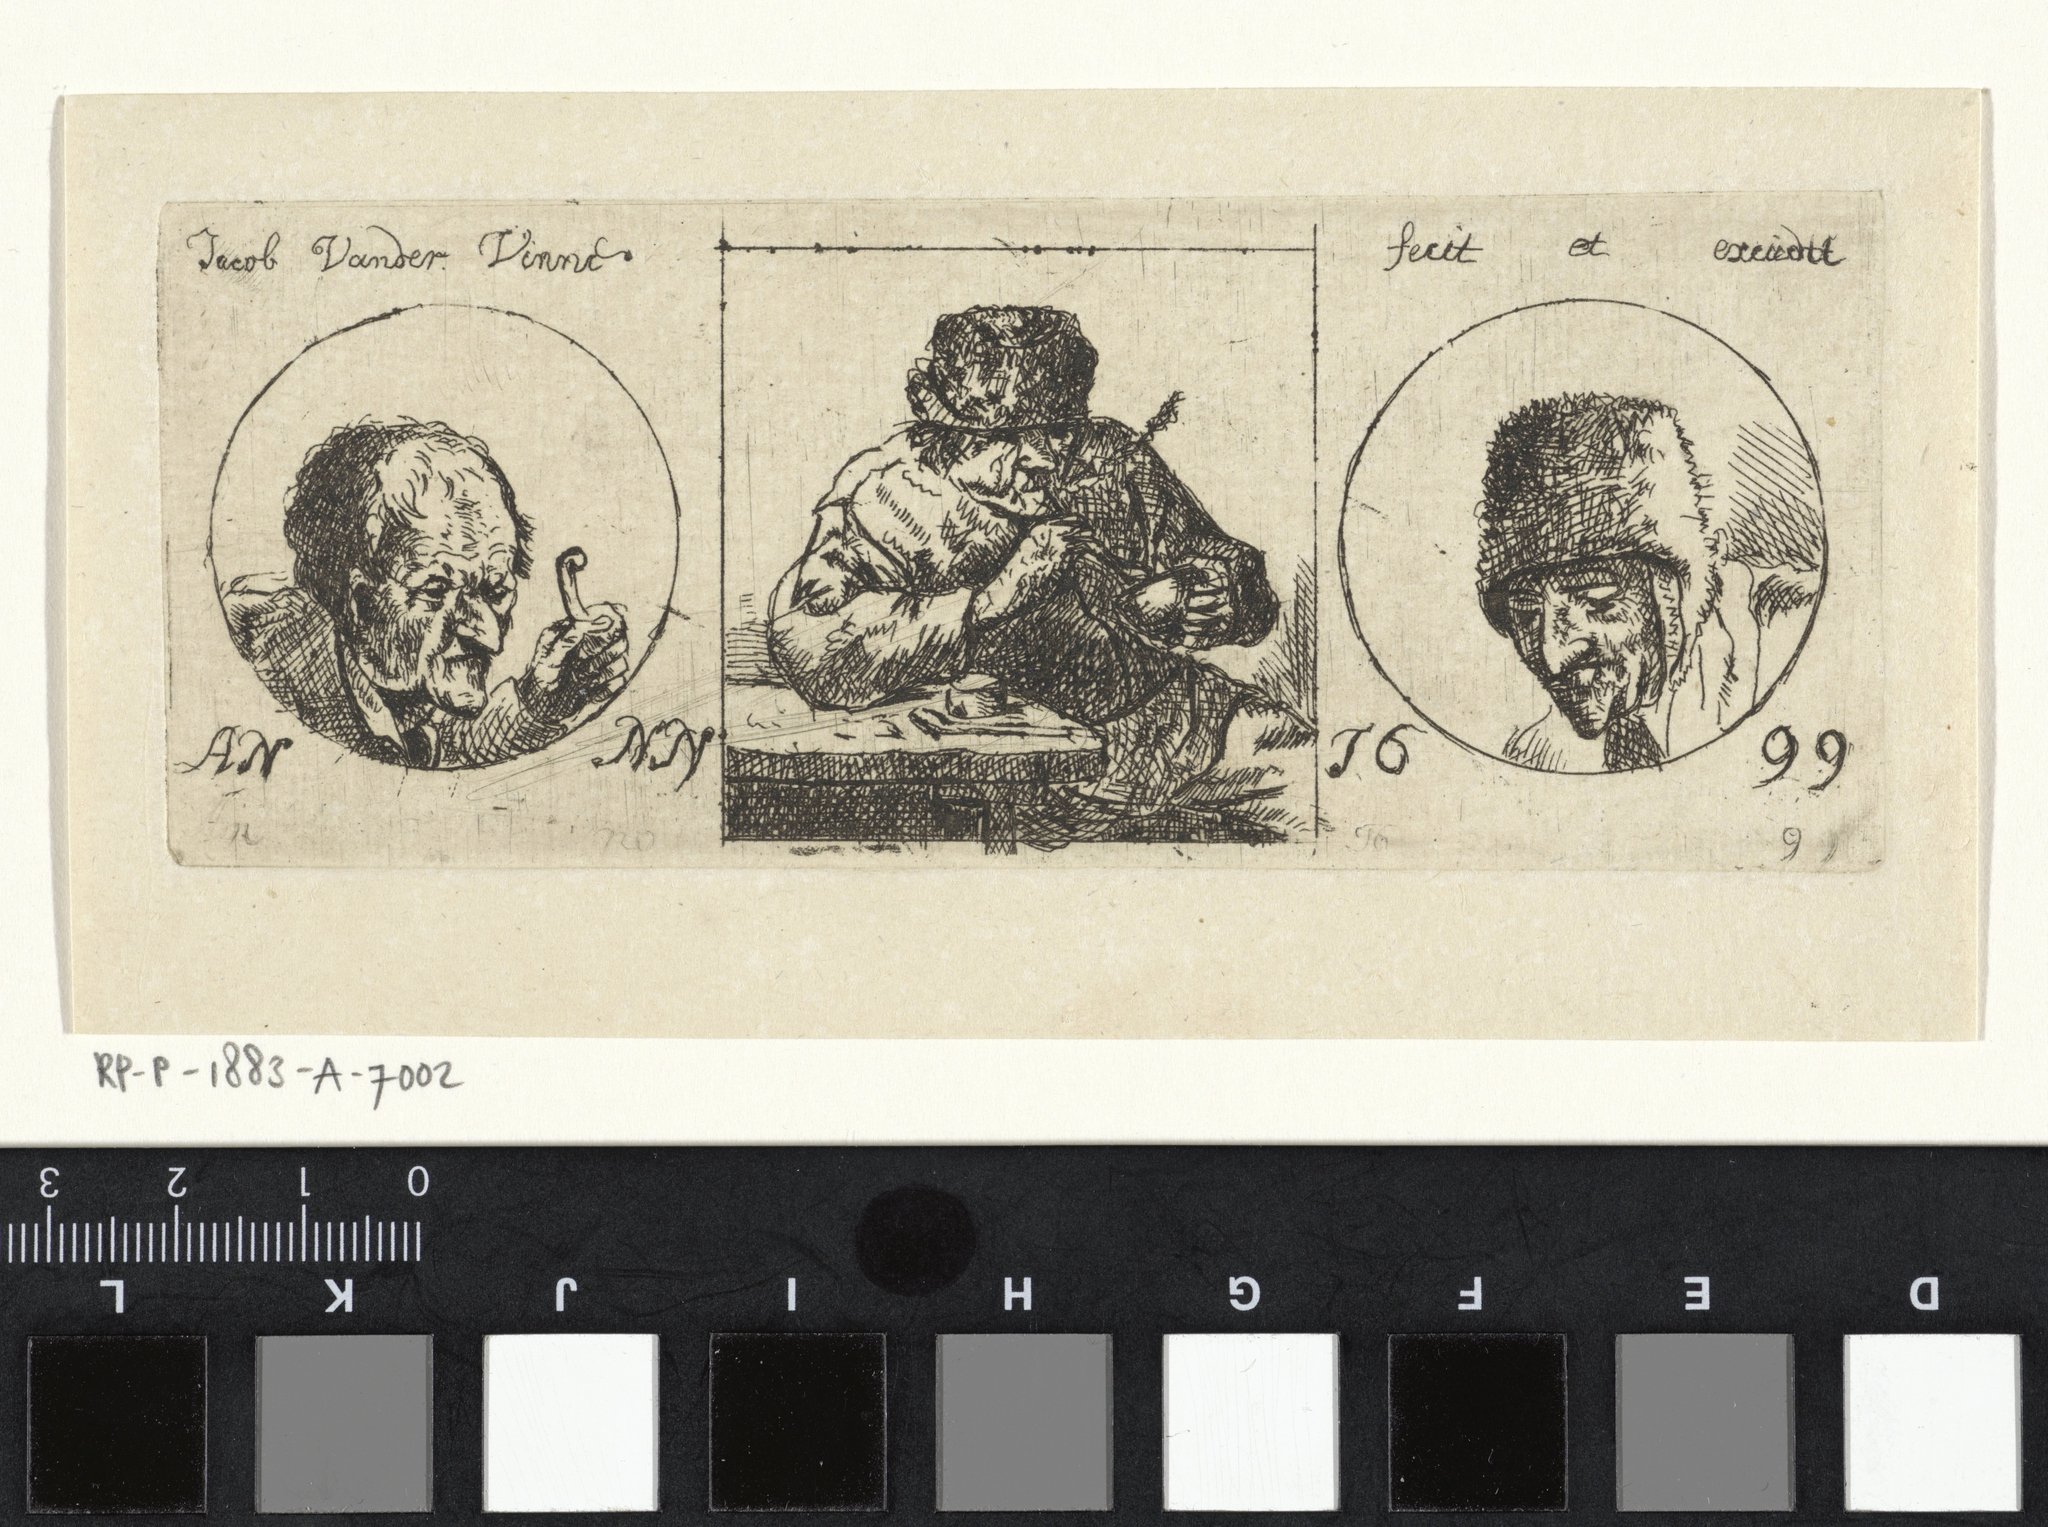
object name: print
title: Twee mannenkoppen en een roker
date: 1699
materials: paper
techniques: etching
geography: haarlem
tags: head-gear: cap (+ men's clothes), pipe ~ tobacco, old man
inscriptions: collector's mark: Lugt 2228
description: Prent maakt deel uit van serie van zes prenten met kopieën naar Adriaan van Ostade. Het RPK heeft er vijf.